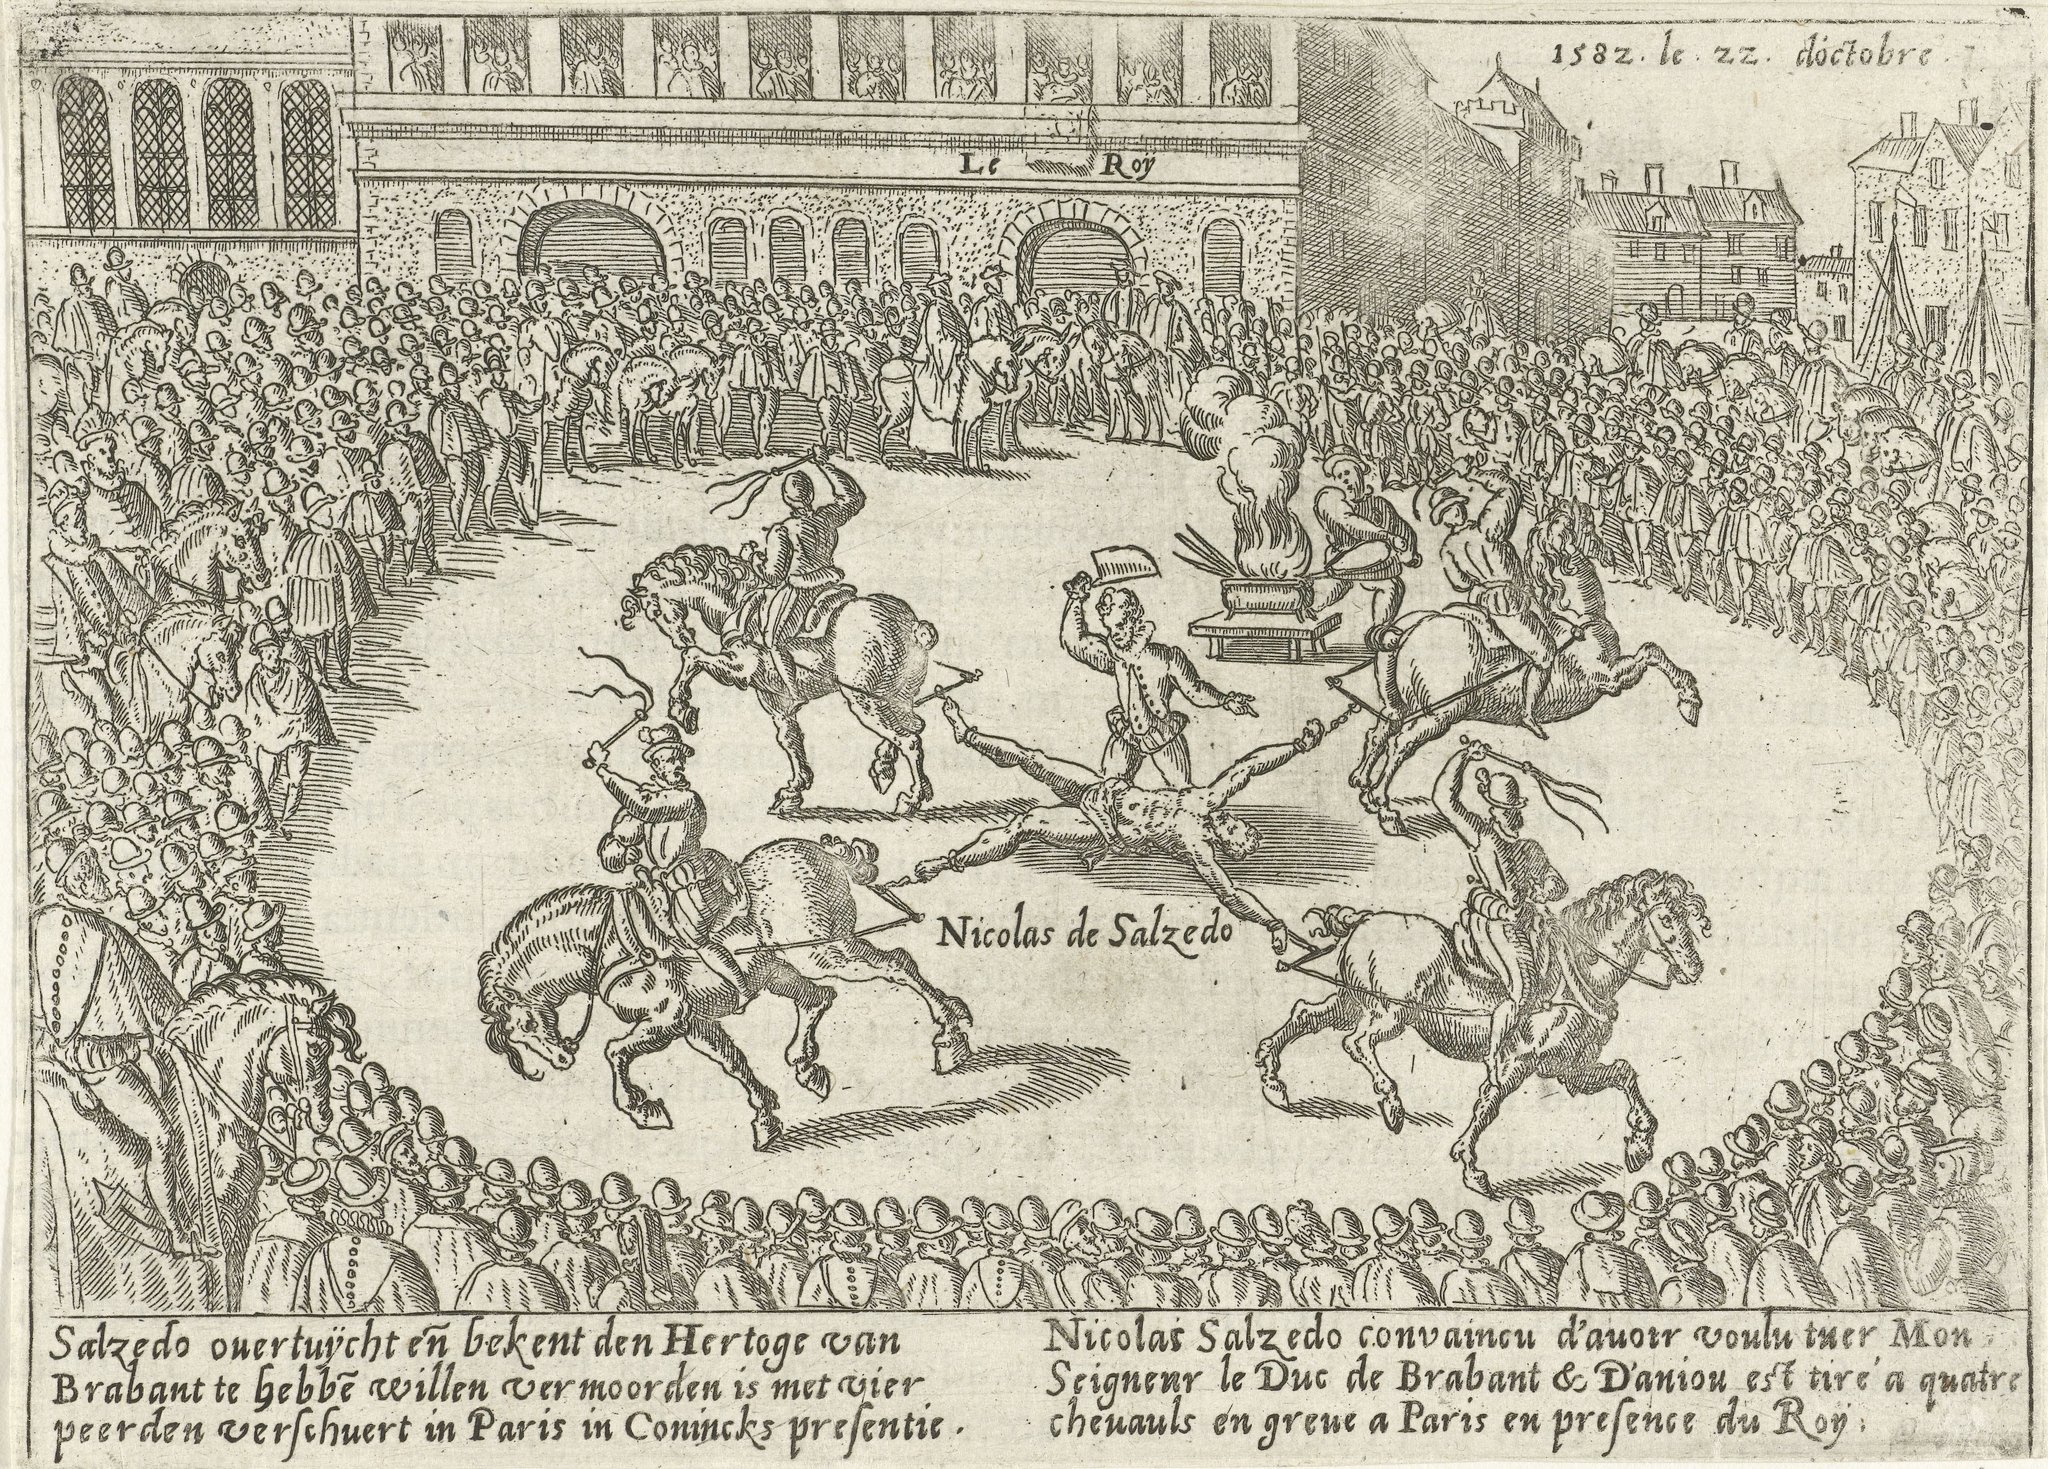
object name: print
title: Executie van Salcedo die samen met Francesco Baza de prins van Oranje en de hertog van Anjou wilde vermoorden, 1582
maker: Anonymous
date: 1613-1615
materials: paper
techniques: etching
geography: northern netherlands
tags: bruges, paris, françois-hercule de valois (hertog van anjou), violent death by quartering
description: Executie te Parijs van Nicolas Salcedo die samen met Francesco Baza de prins van Oranje en de hertog van Anjou wilde vermoorden, 22 of 25 oktober 1582. Salcedo wordt op een plein met veel toeschouwers en in aanwezigheid van de koning gevierendeeld. Met onderschrift van 3 regels in het Nederlands en 3 regels in het Frans. Ongenummerd. Bedrukt op achterzijde met tekst in het Latijn.